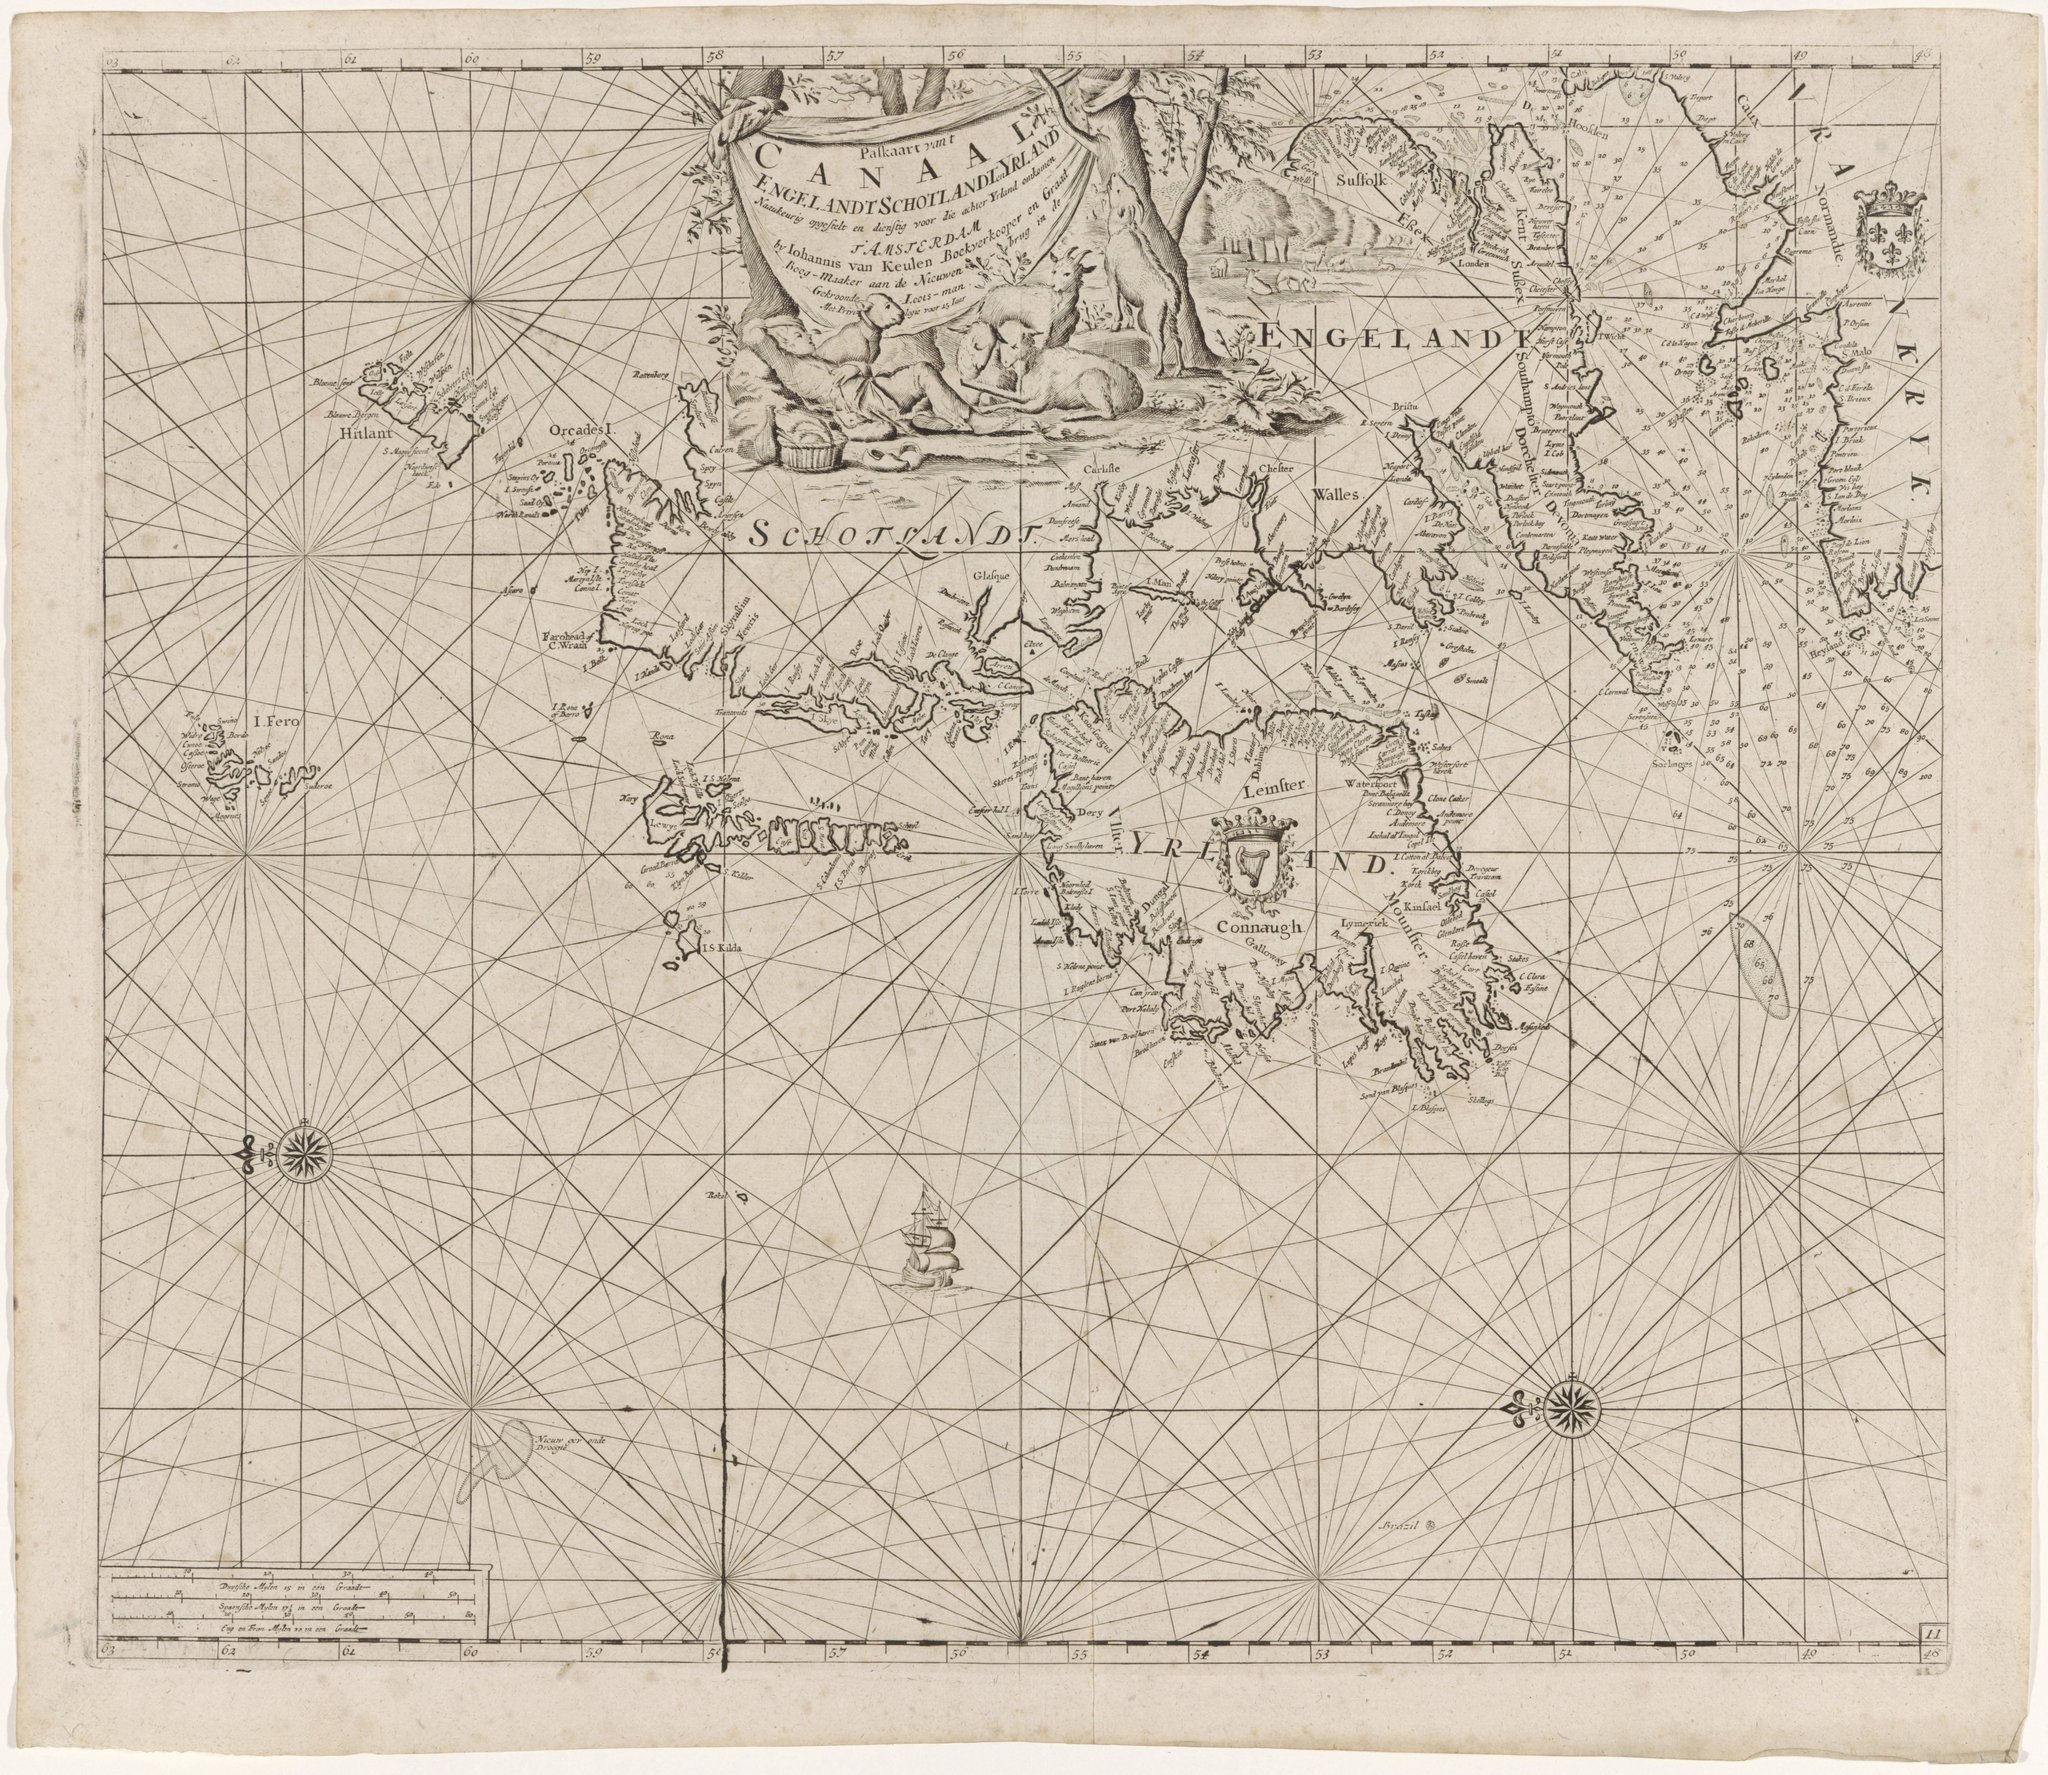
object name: print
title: Paskaart van't Canaal Engelandt Schotlandt en Yrland Naaukeurig opgestelt en dienstig voor die achter Yrland omkomen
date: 1681-1803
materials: paper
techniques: engraving, etching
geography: amsterdam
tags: sailing-ship, sailing-boat, herding, herdsman, herdswoman, shepherd, shepherdess, cowherd, etc., sheep, sleeping on the ground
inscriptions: collector's mark: Lugt 2228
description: Paskaart van de kust van Ierland en een gedeelte van de kusten van Schotland, Engeland en Frankrijk, met twee kompasrozen, het Noorden ligt links. Middenboven ligt een herder met zijn schapen te dutten onder de cartouche met de titel en het adres van de uitgever. Linksonder de schaalverdeling, weergegeven in Duitse, Spaanse en Engelse of Franse mijlen.